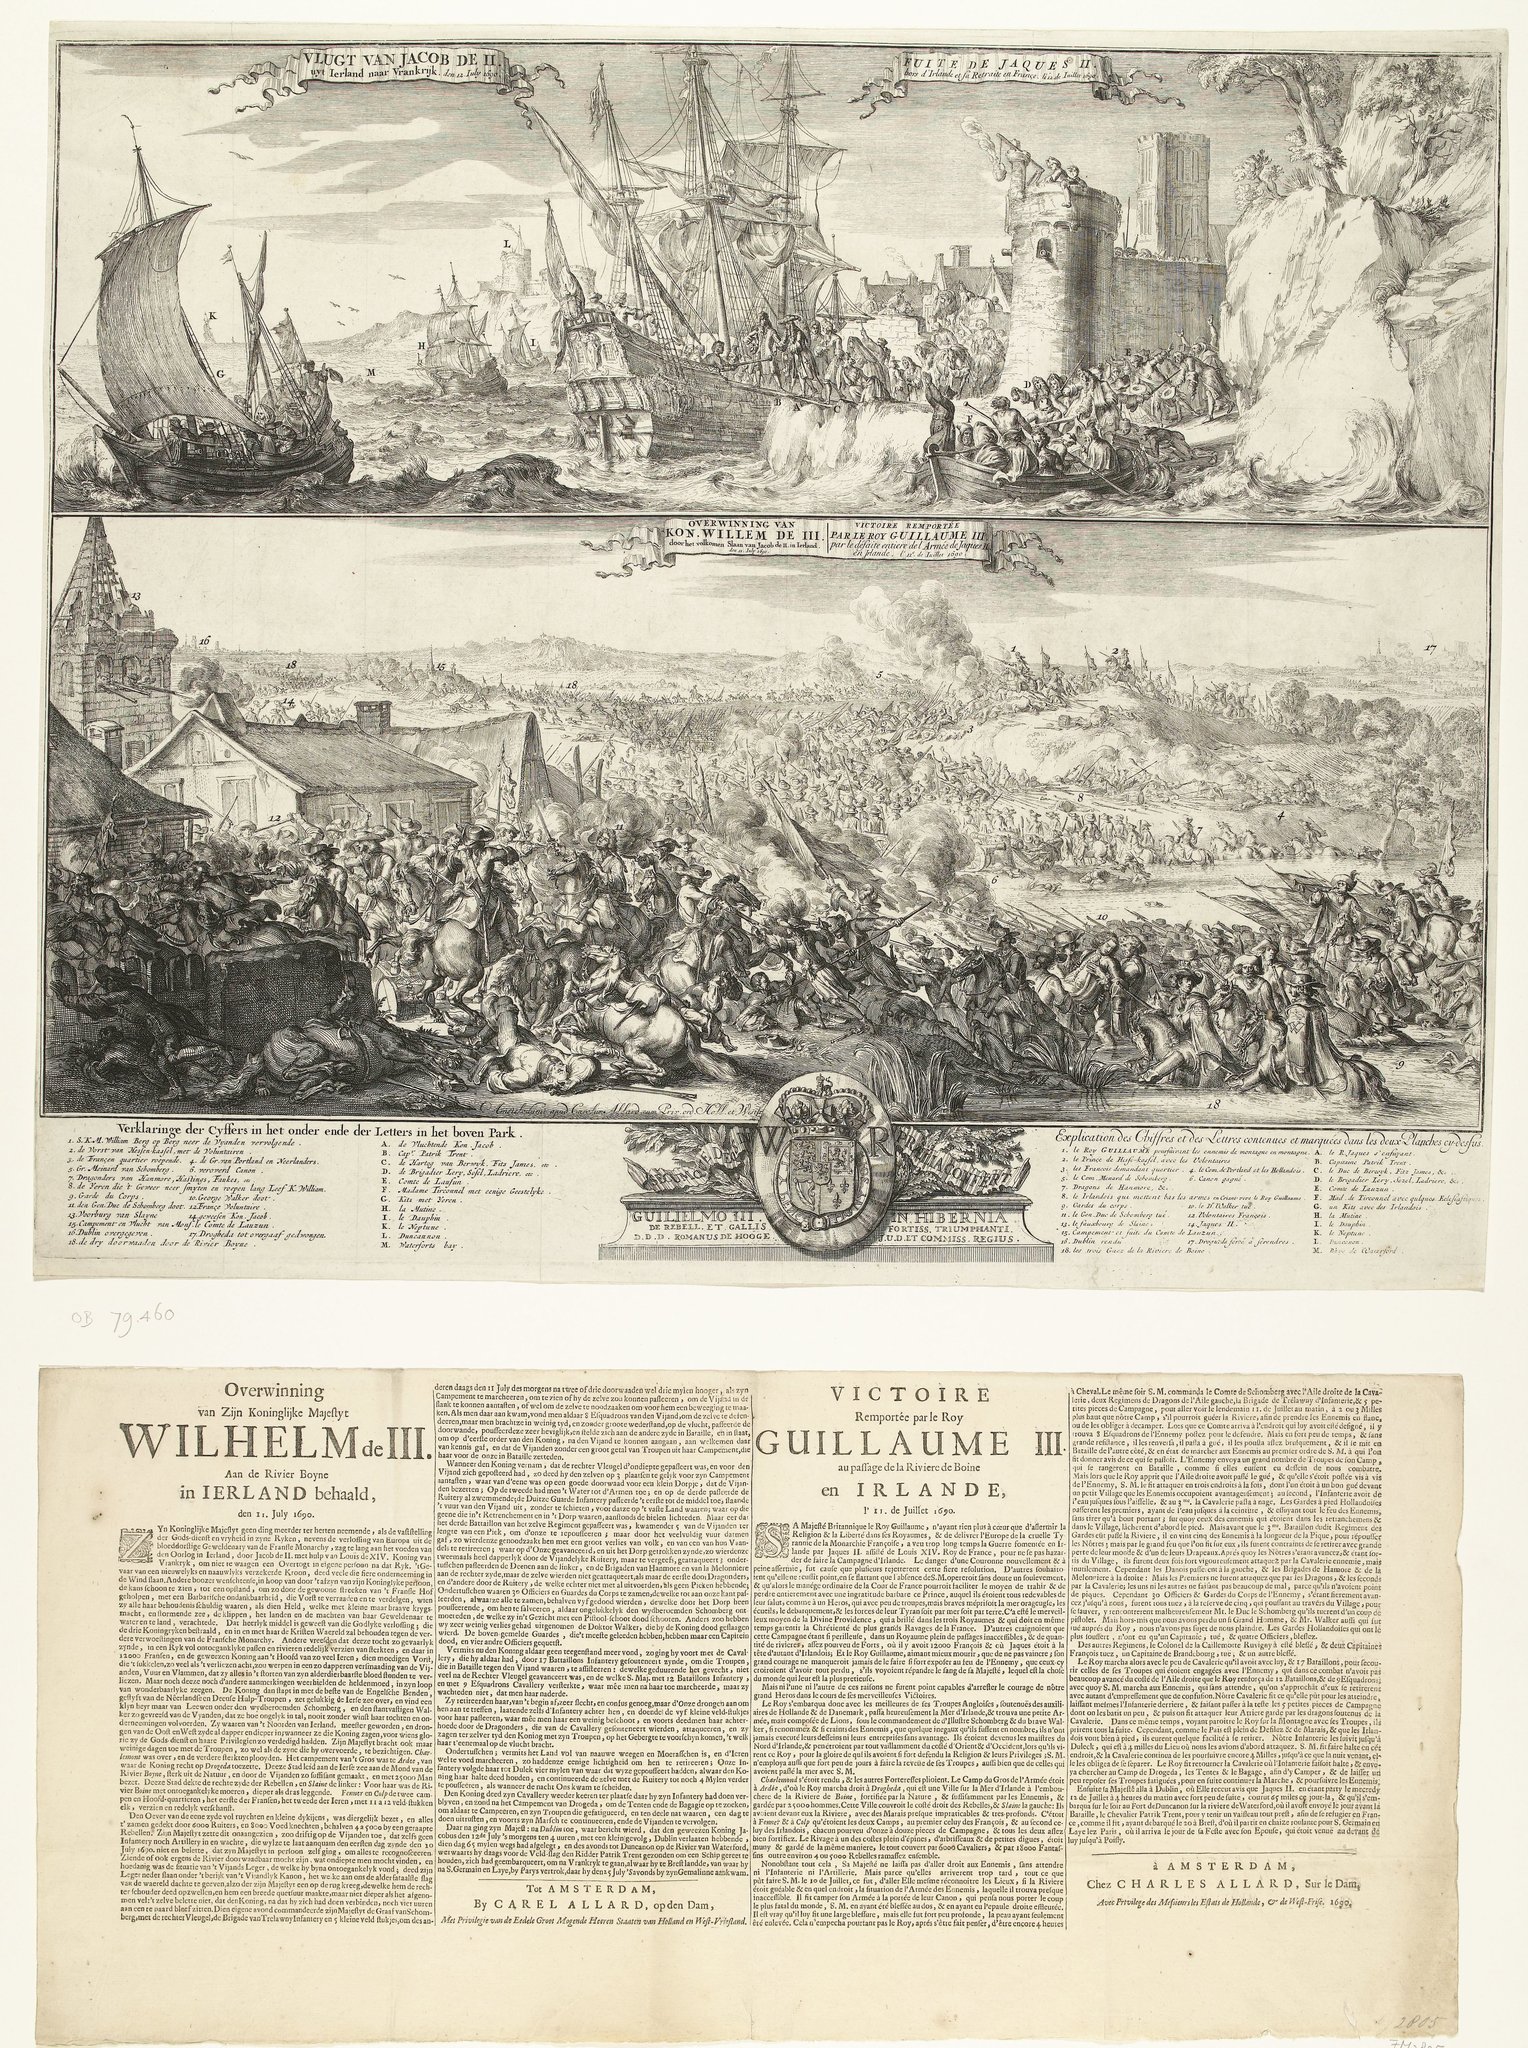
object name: print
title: Overwinning van Kon. Willem de III. door het volkomen Slaan van Jacob de II. in Ierland. den 11. Iuly 1690 / Victoire remportée par le roy Guillaume III, par le défaite entiere de l'Armée de Jaques II. en Irlande. l' 11 Iuillet 1690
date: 1690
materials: paper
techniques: etching, letterpress printing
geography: northern netherlands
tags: jacobus ii (koning van engeland en schotland), the hague, william iii (prince of orange and king of england, scotland, and ireland), battle (+ land forces)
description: De vlucht van Jacobus II en de overwinning van Willem III aan de Boyne, 11 juli 1690. Twee voorstellingen boven elkaar op één blad. In het onderschrift de legenda's 1-18 en A-M in het Nederlands en Frans. Hierbij een los tekstblad met beschrijving van de voorstelling in 4 kolommen in het Nederlands en Frans.